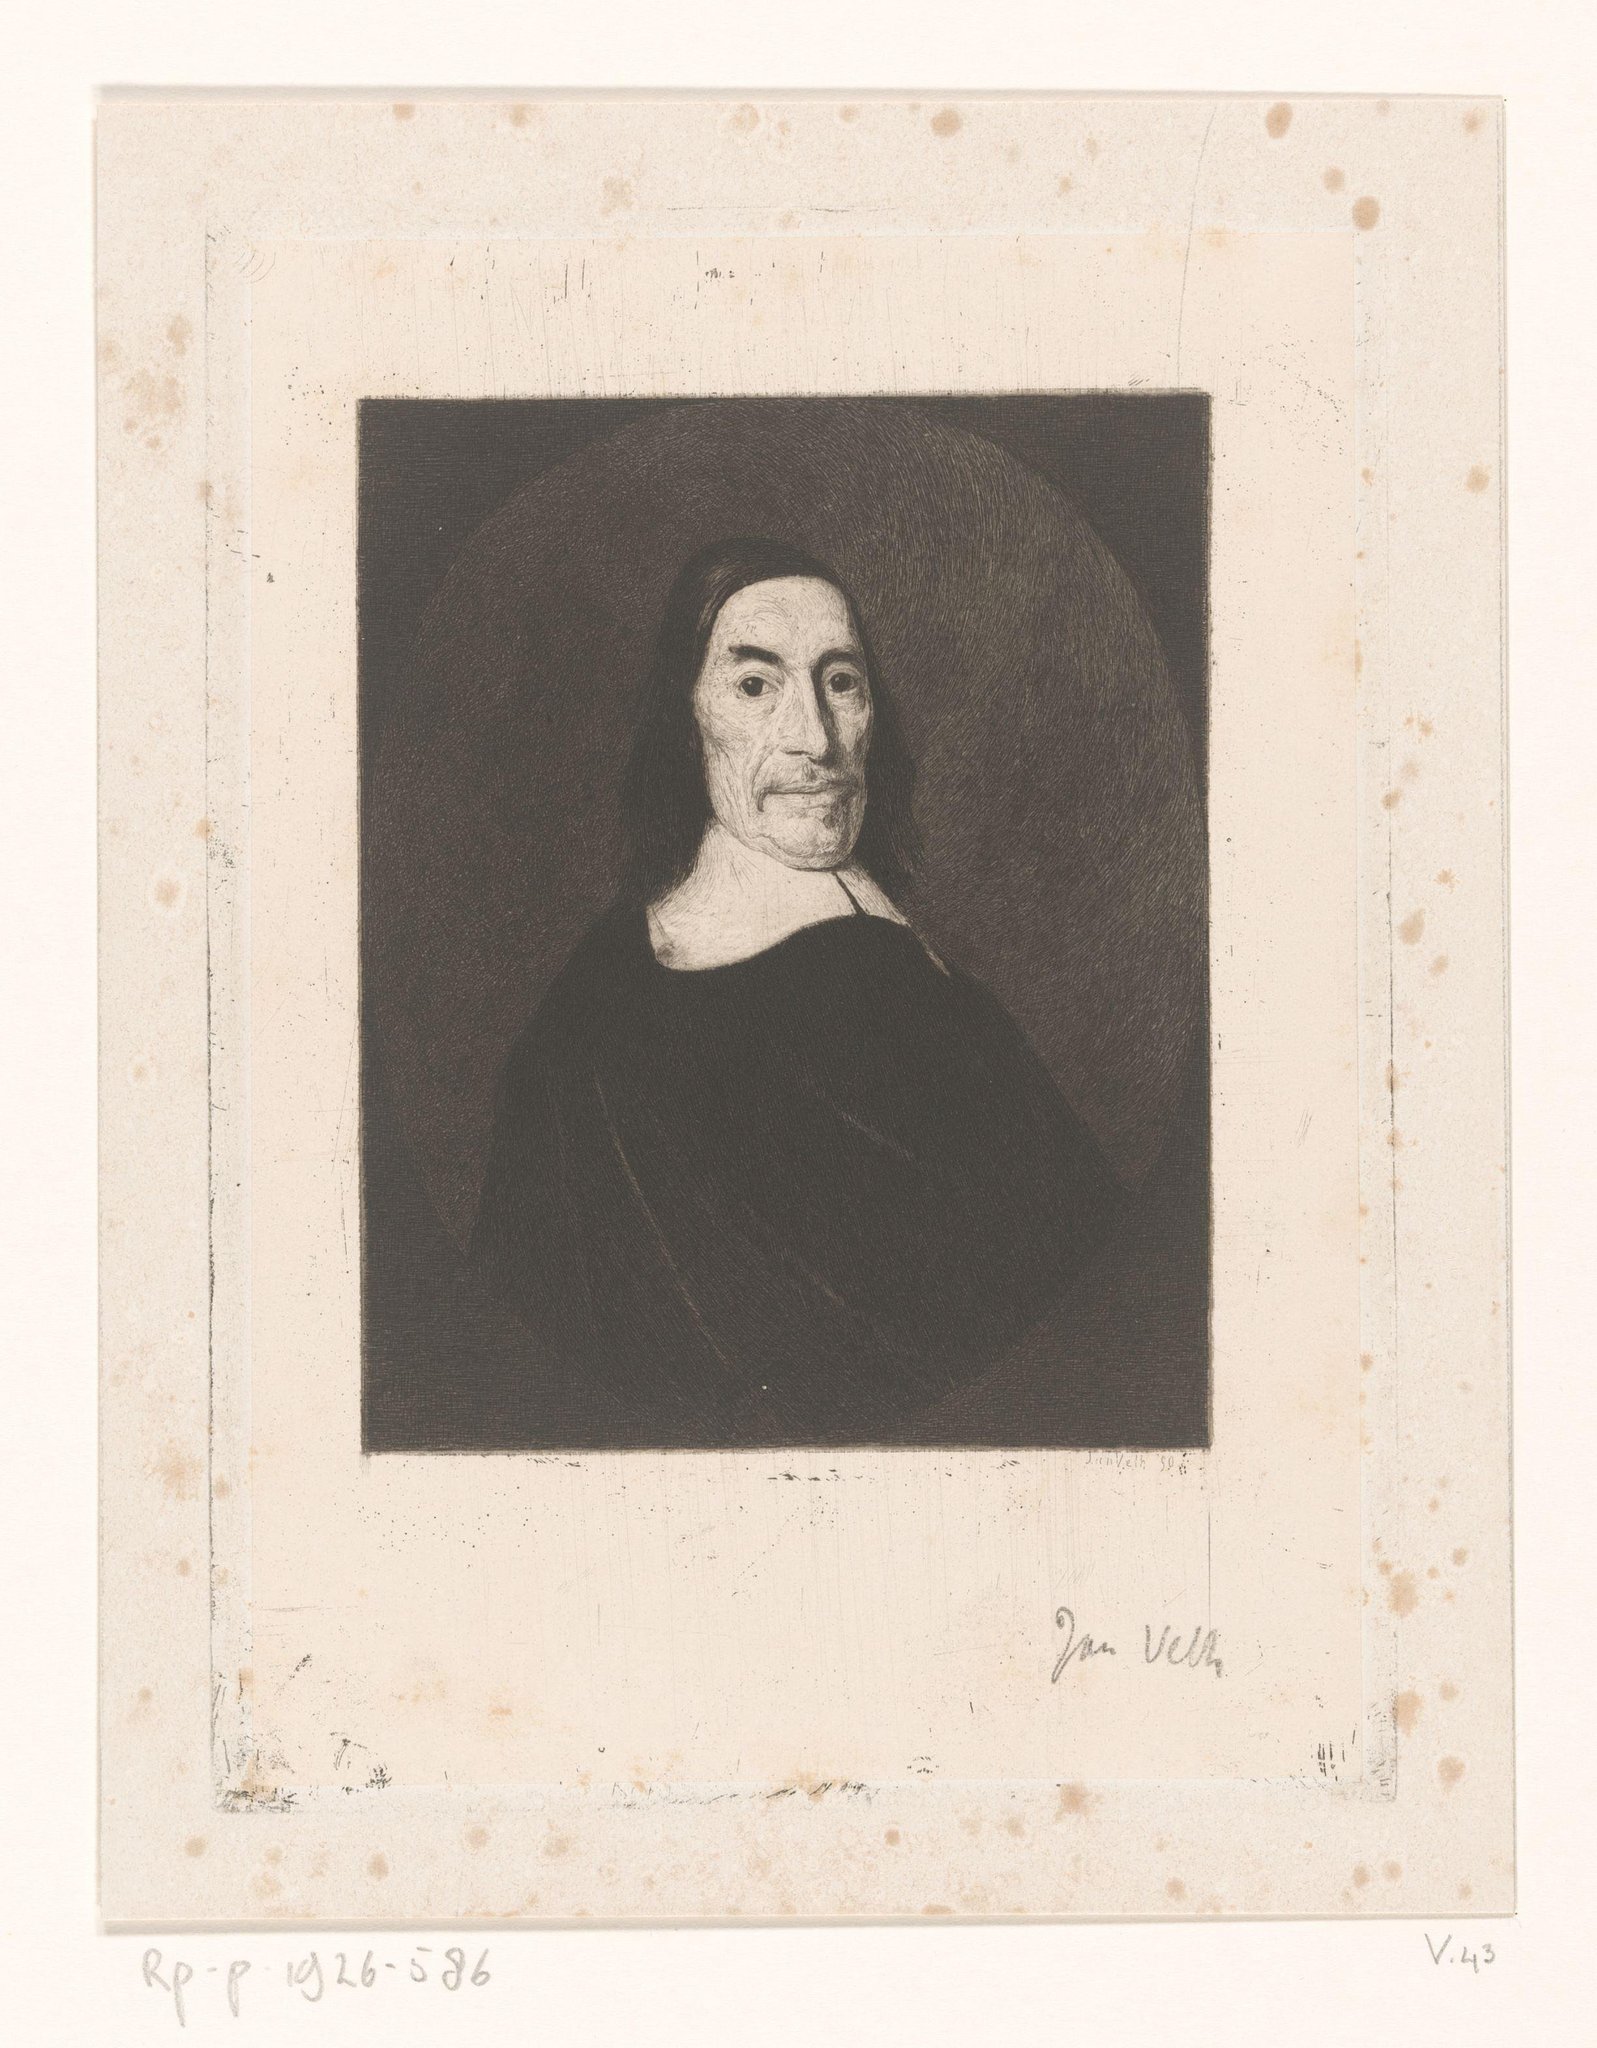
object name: print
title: Portret van Jacob de Witt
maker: jan veth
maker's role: designer, draughtsman, painter, print maker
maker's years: 1864-1925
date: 1890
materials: paper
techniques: etching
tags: mayor, historical persons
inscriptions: collector's mark: Lugt 2228